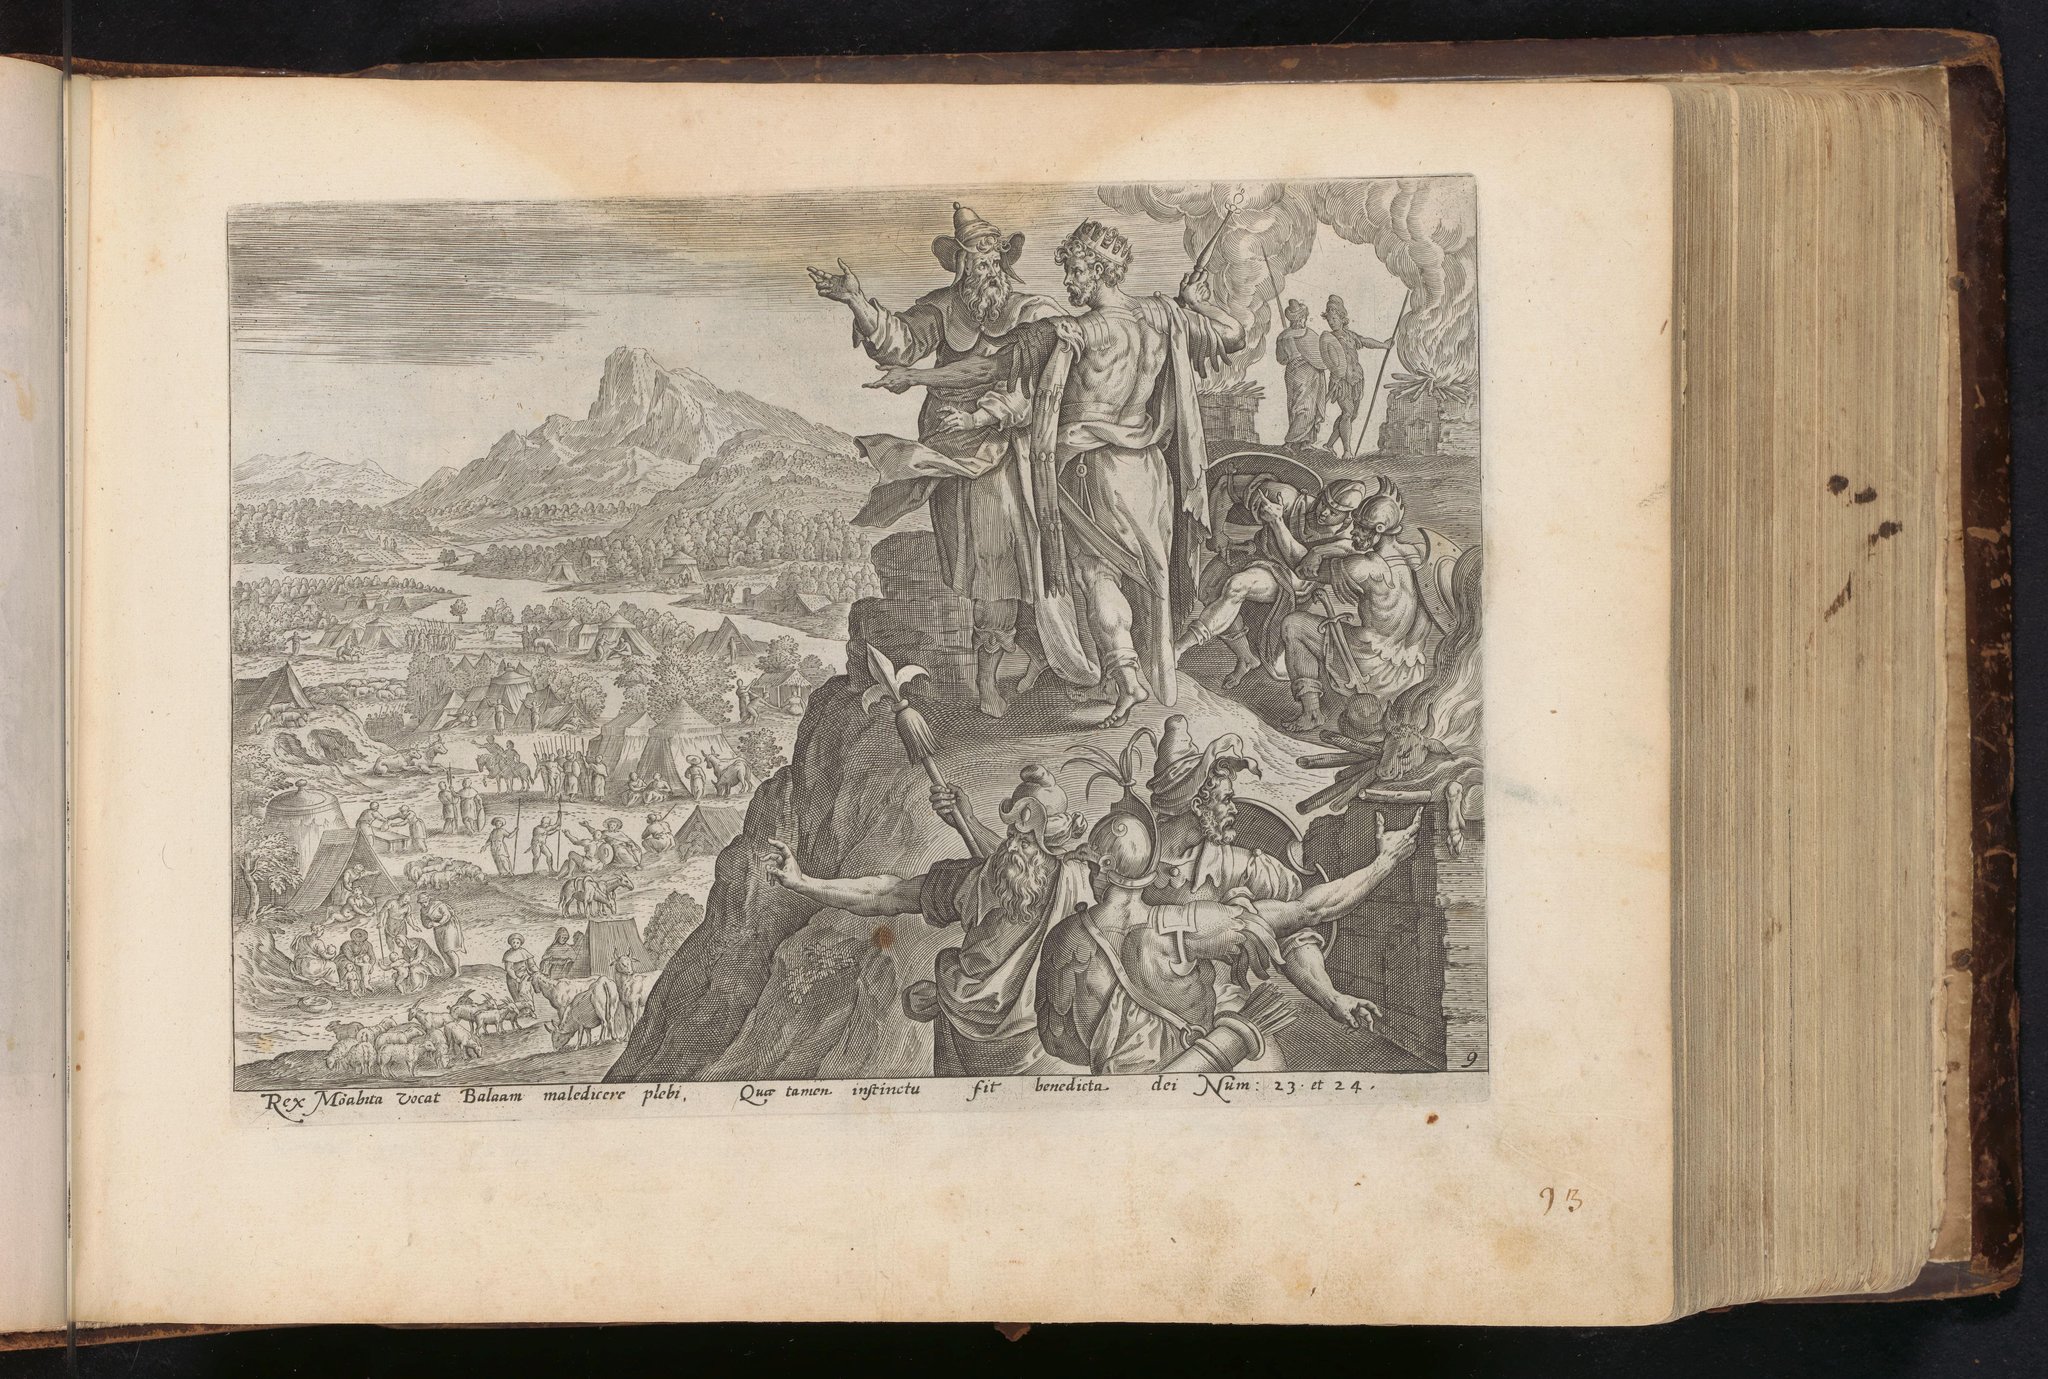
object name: album leaf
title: Geschiedenis van Bileam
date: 1585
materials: paper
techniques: engraving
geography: alkmaar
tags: balaam is taken up to the high places of baal and sees the israelite camp, balaam prophesying and blessing the israelites in the presence of king balak and his chieftains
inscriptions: number: ‘93’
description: Bileam staat met Balak, de koning van Moab, op een berg en zij kijken uit over het tentenkamp van de Israëlieten. Balak wil dat Bileam het volk vervloekt, maar Bileam zegent ze juist. Op de berg zijn altaren opgericht en er staan Moabitische strijders. Onder de voorstelling een verwijzing in het Latijn naar de Bijbeltekst in Num. 23-24. Deze prent maakt deel uit van een album.